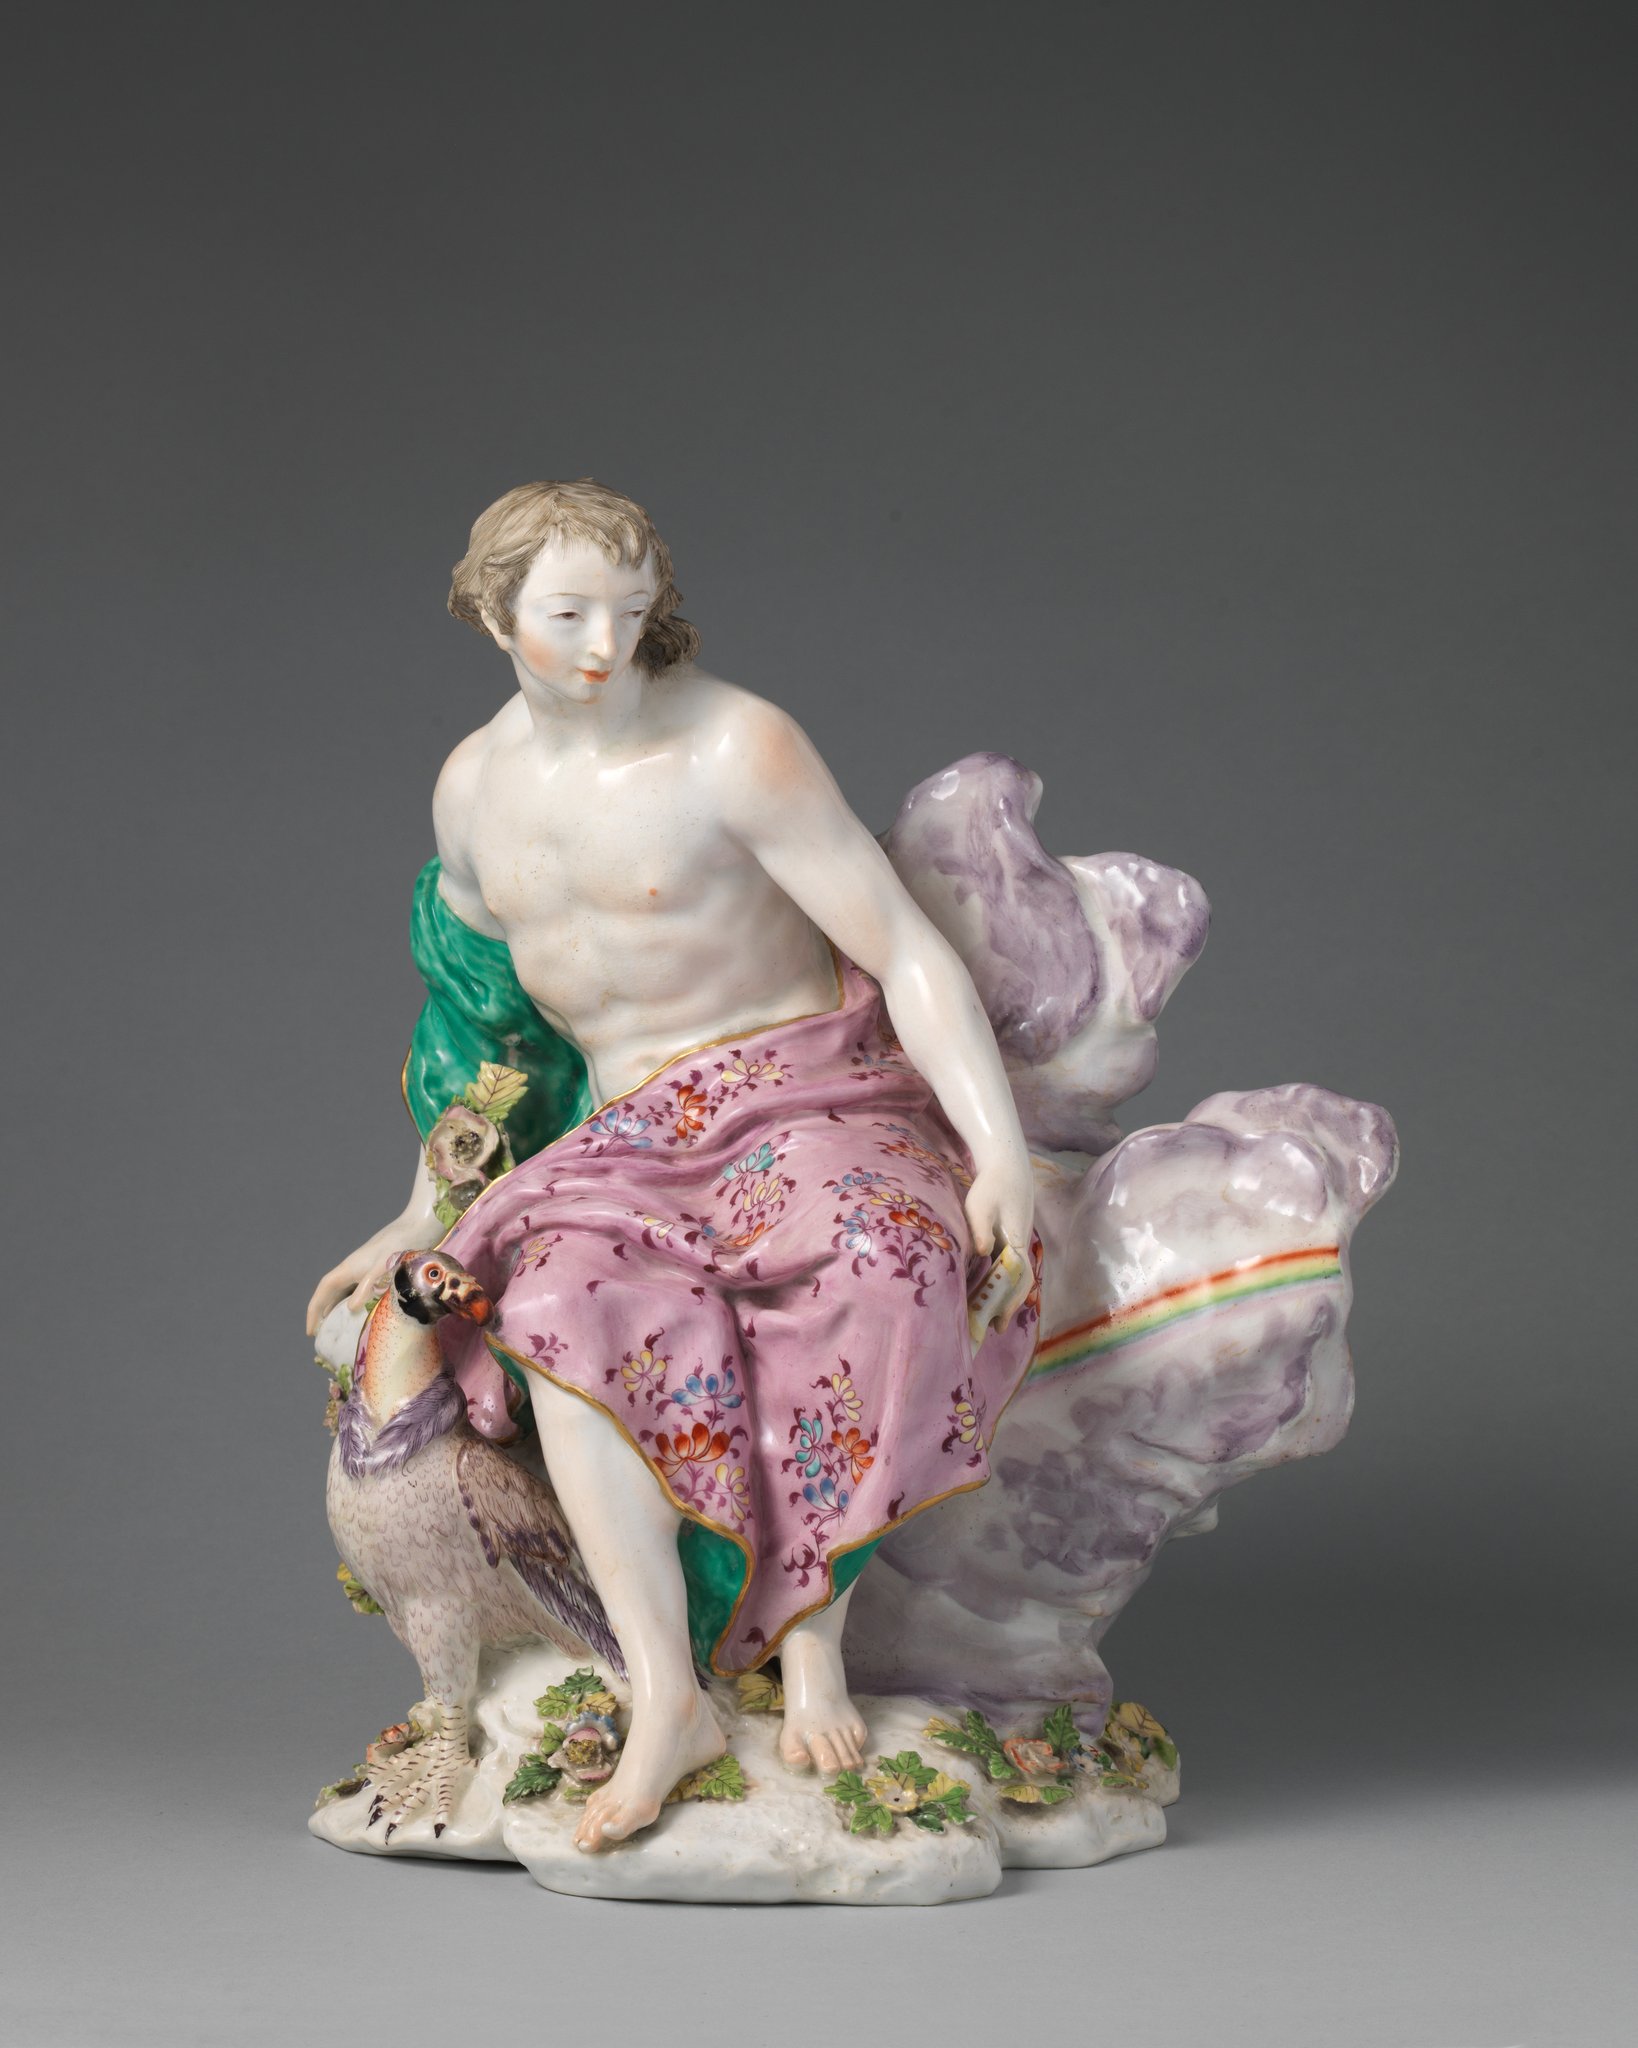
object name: figure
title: Sight (one of a pair)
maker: chelsea porcelain manufactory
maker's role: factory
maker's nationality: british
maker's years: 1744-1784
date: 1755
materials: enamel, soft paste porcelain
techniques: gilding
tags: birds,men,leaves